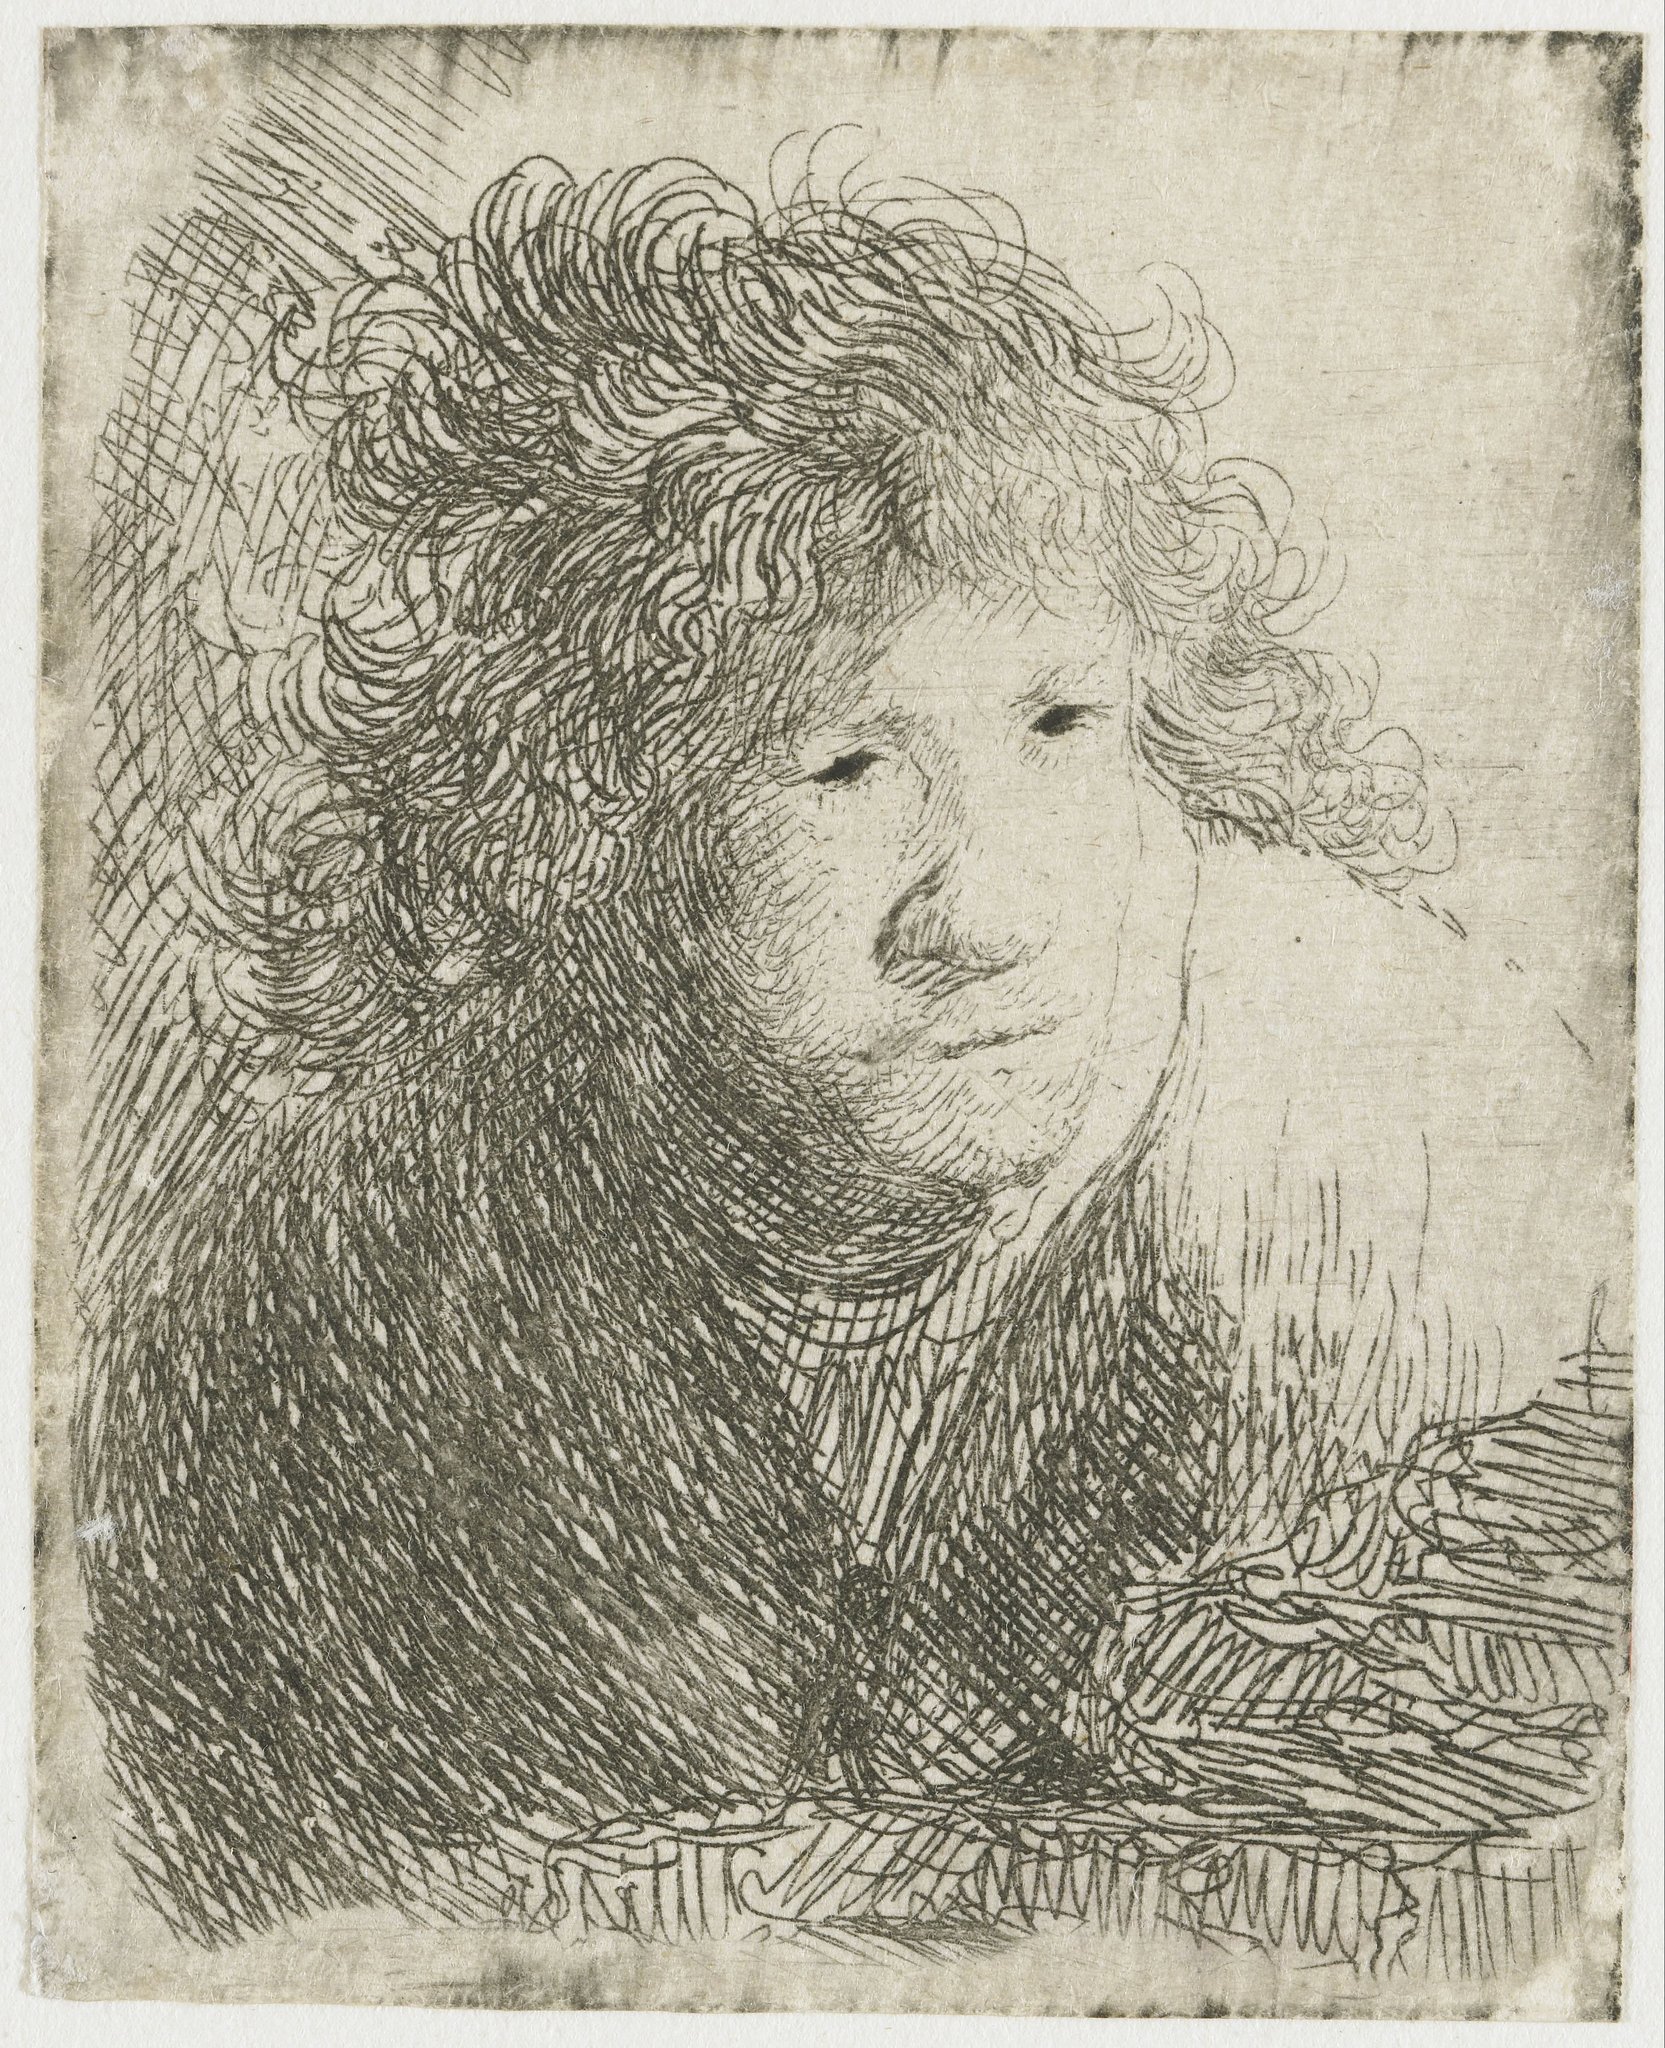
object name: print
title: Self-portrait, leaning forward, listening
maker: rembrandt van rijn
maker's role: draughtsman, painter, print maker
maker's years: 1606-1669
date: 1628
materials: paper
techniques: etching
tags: leiden, amsterdam, print maker, draughtsman, rembrandt van rijn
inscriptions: collector's mark: Lugt 240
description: Rembrandt was fascinated by the effects of light. This is also clear in his etchings, for instance in these diminutive self-portraits in which his face is mostly half cast in shadow. In the version with a fur cap, we can see that this head covering was added only at a later stage. He began the etching with a bare head: his hair is still visible through the cap.